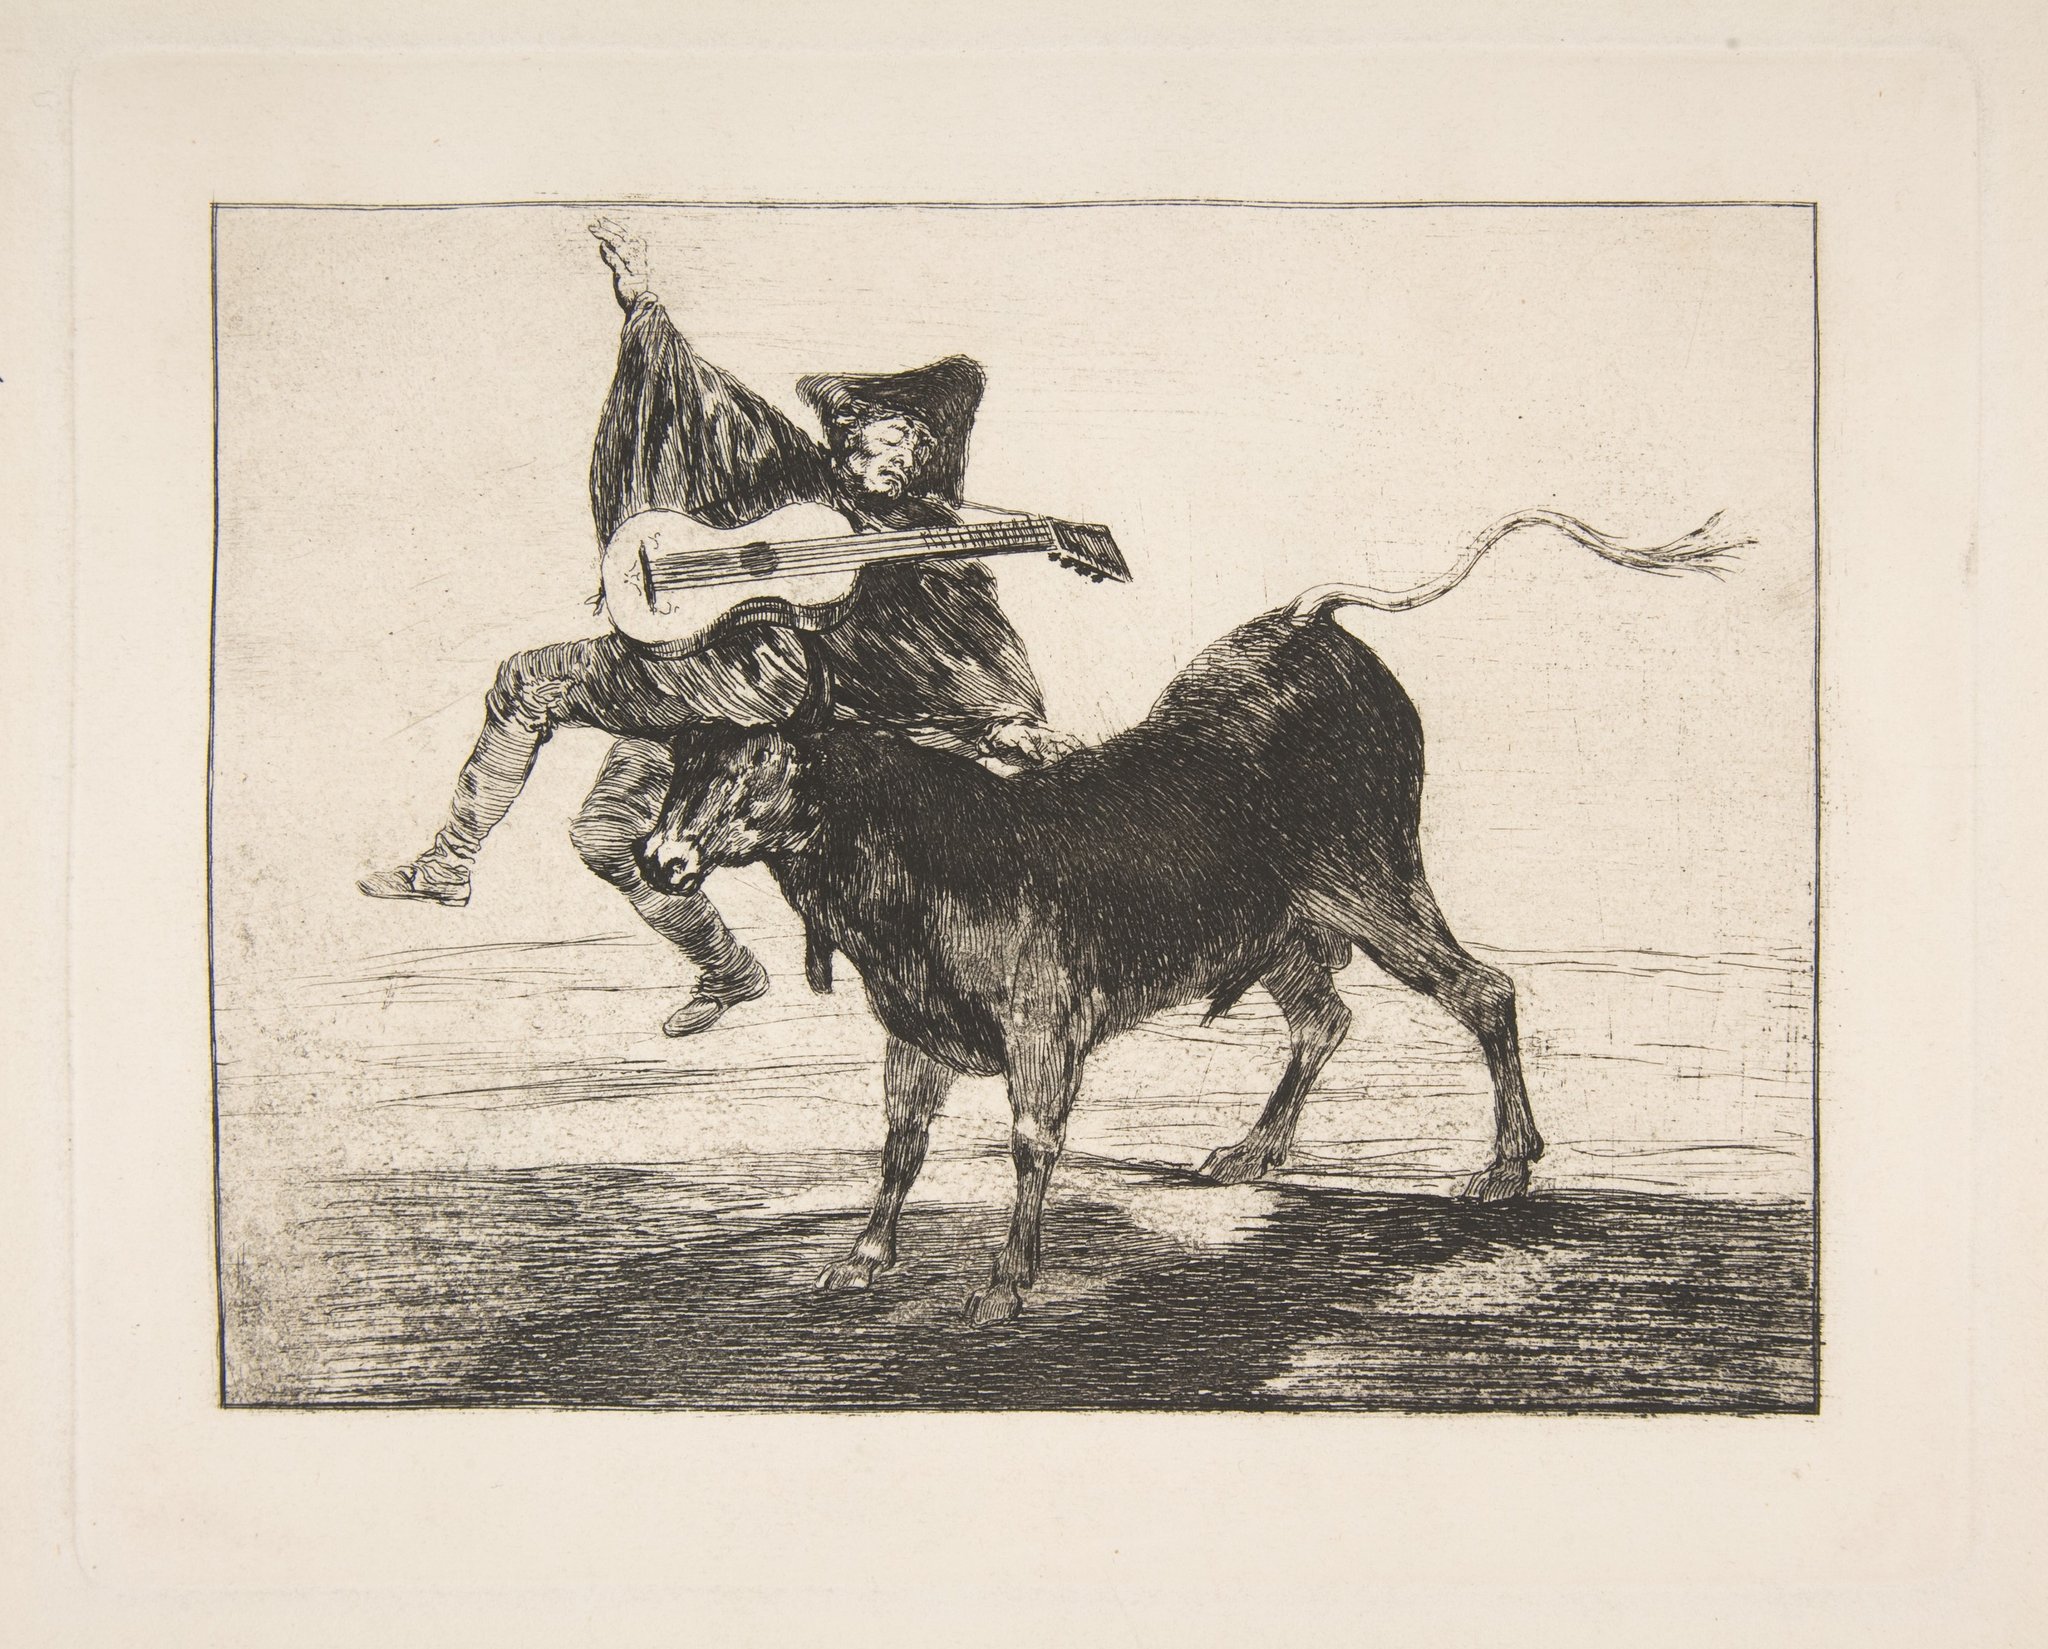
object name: print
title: 'Barbarous Entertainment', a blind guitarist on the horns of a bull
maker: goya (francisco de goya y lucientes)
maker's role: artist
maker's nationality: spanish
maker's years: 1746-1828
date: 1800-1804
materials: paper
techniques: aquatint, drypoint, etching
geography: spain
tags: men,guitars,bulls